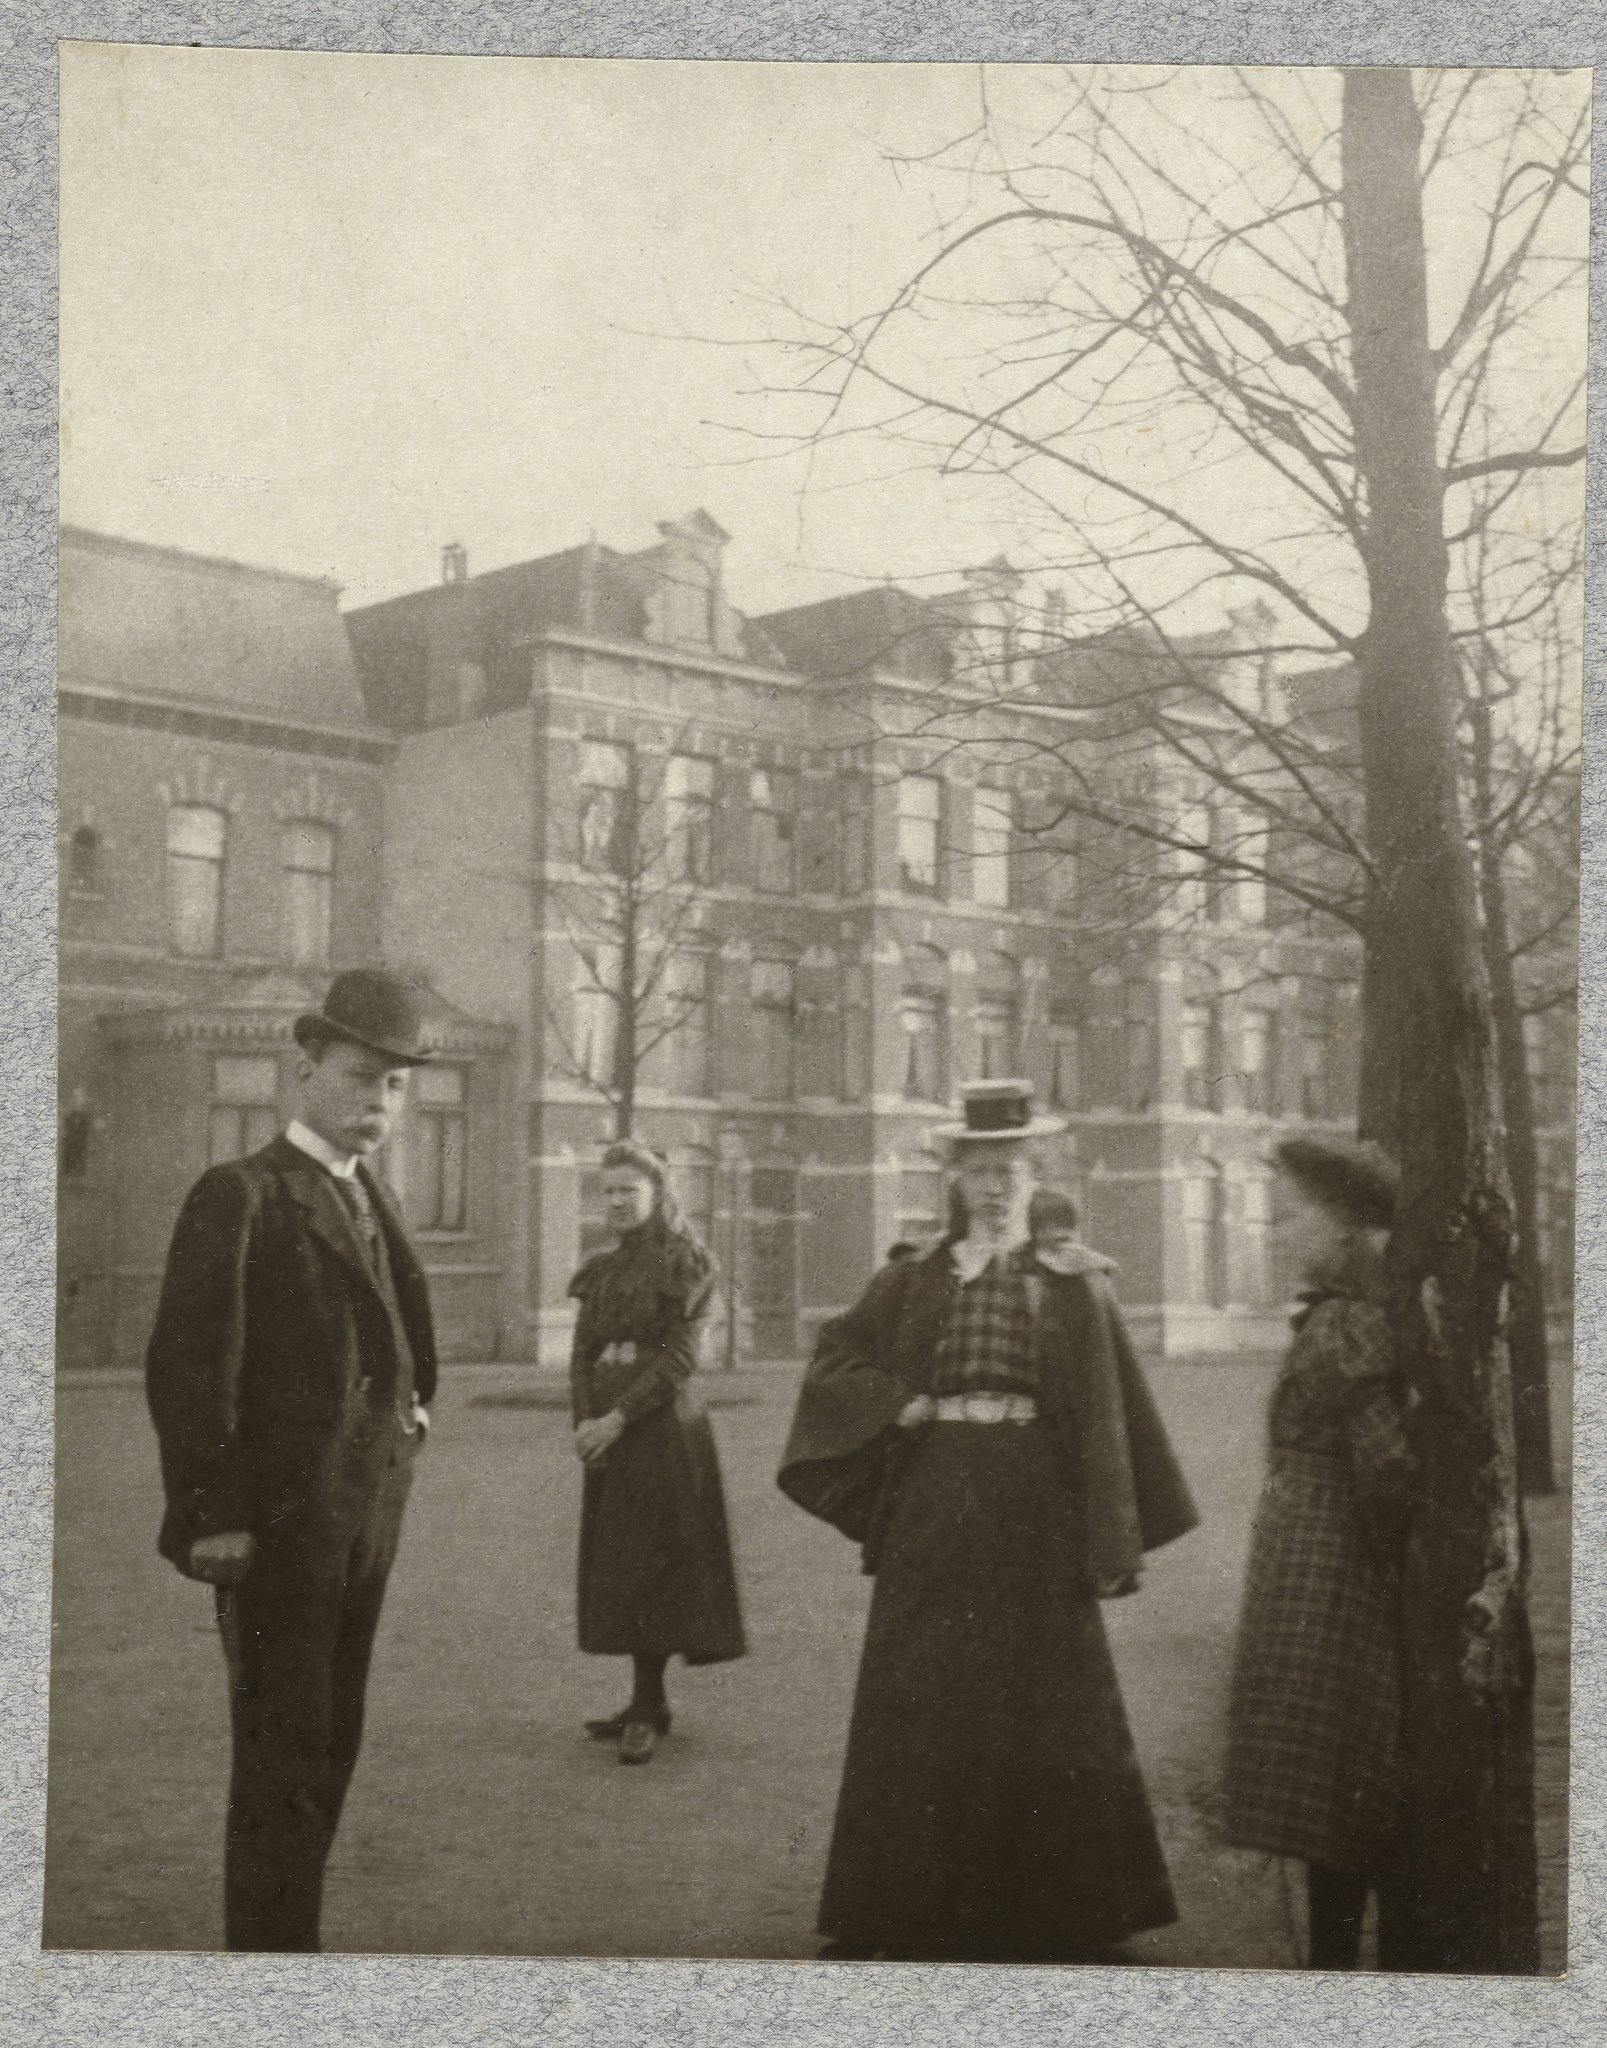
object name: photograph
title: Portret van J.B. Aug Kessler en zijn dochters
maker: geldolph adriaan kessler (dolph)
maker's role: fotograaf, industrieel, voetballer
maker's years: 1884-1945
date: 1900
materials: paper, photographic support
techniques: gelatin silver print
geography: netherlands